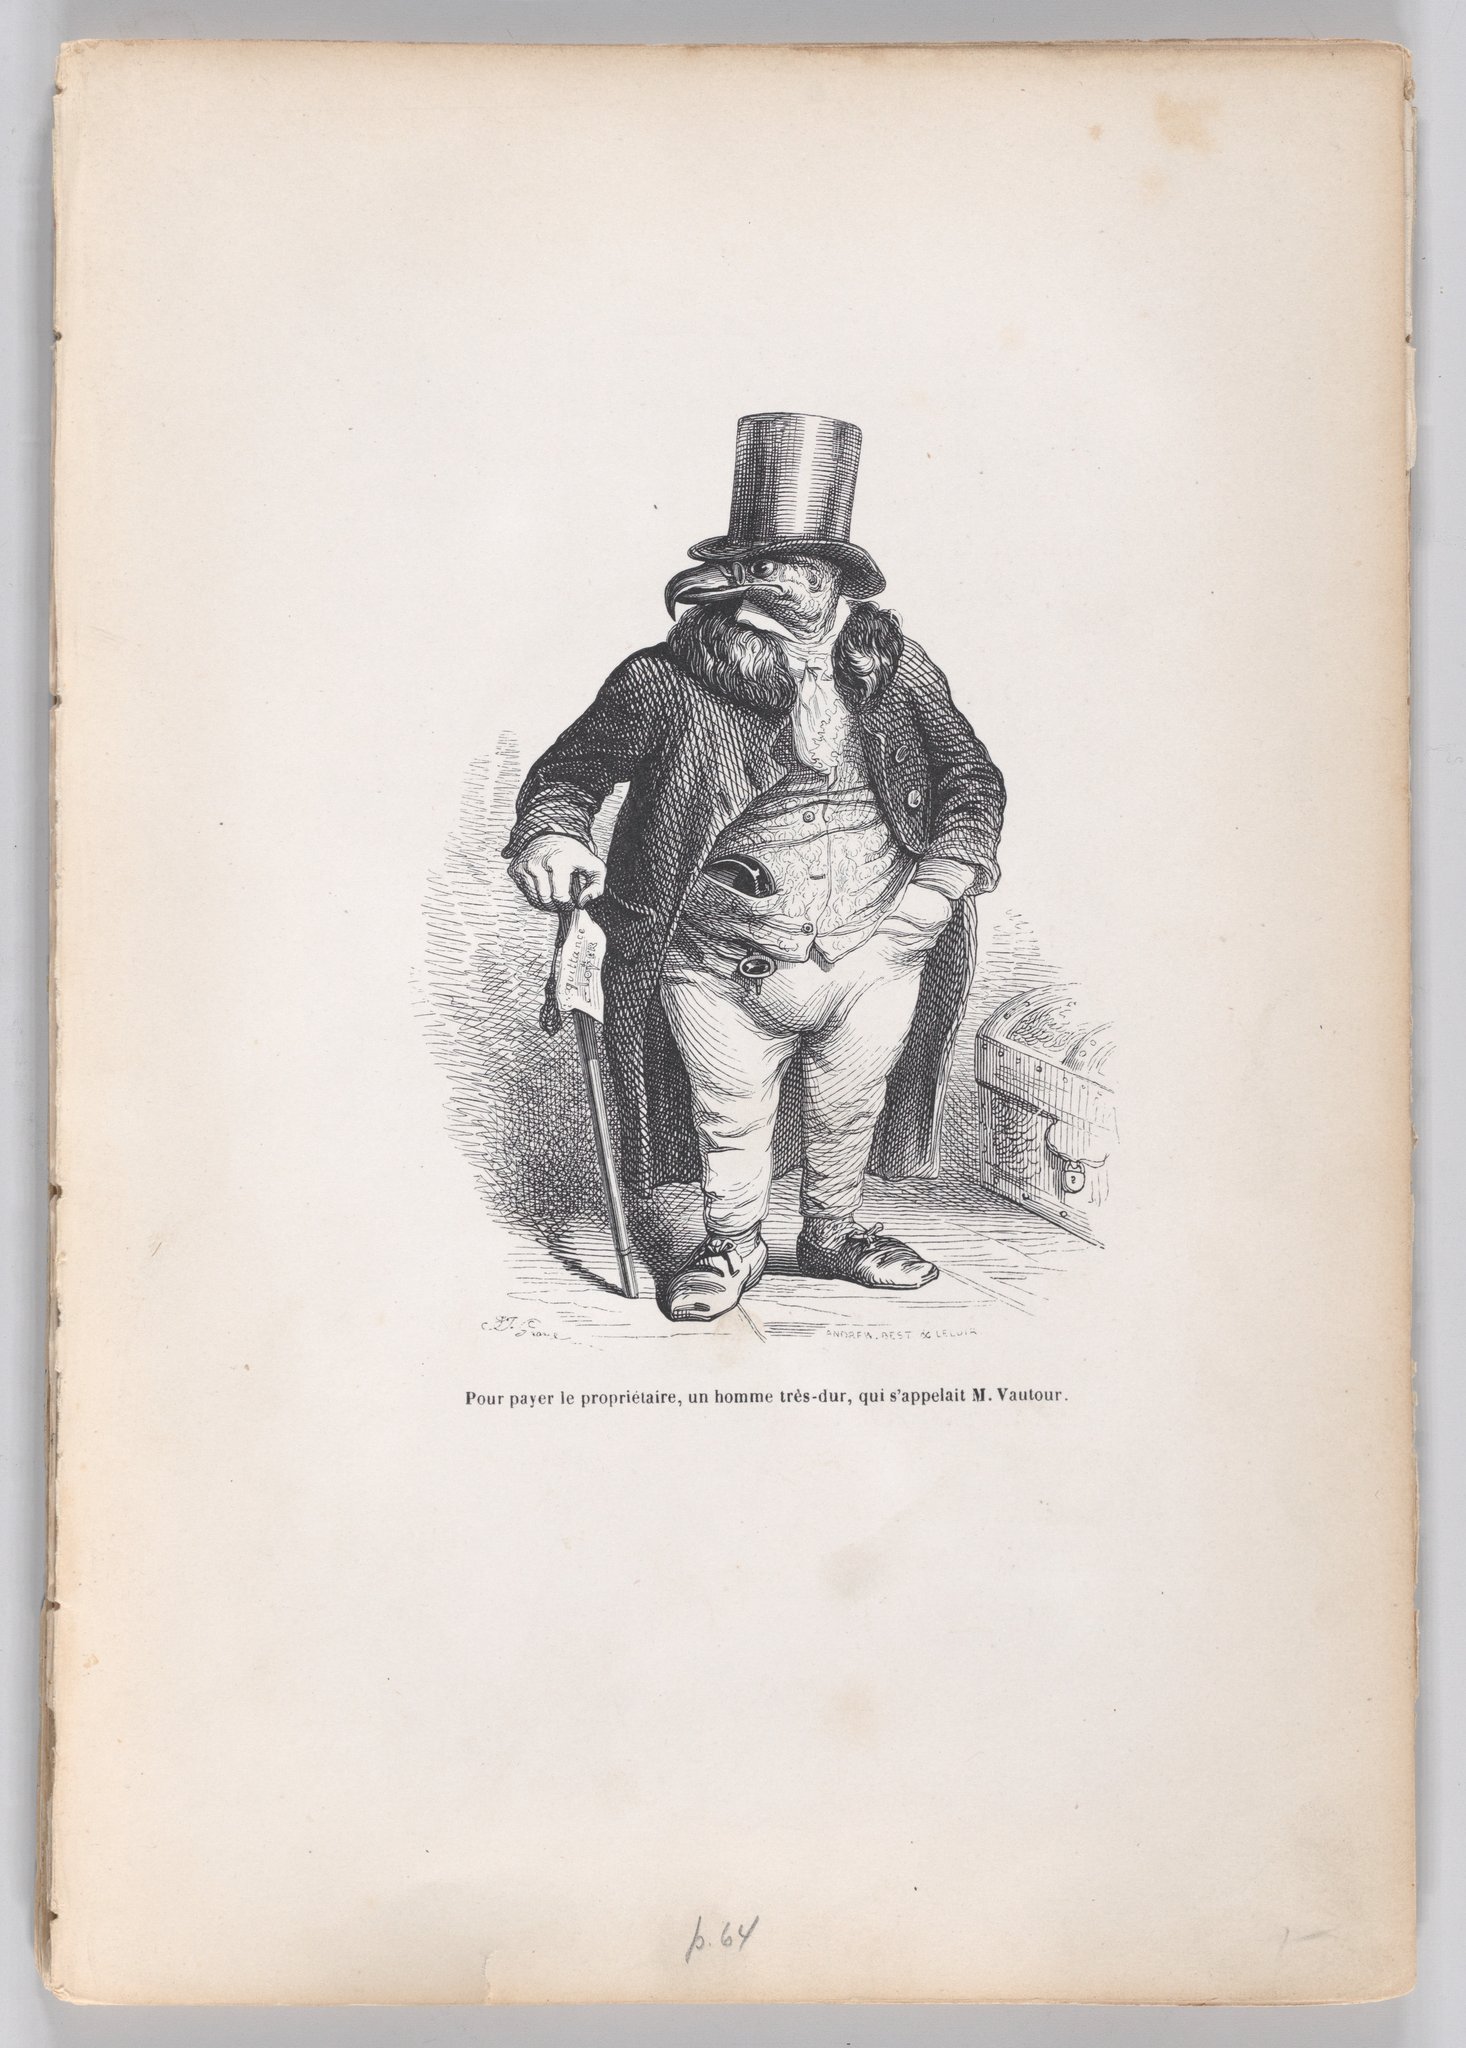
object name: print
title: To pay the landlord, a very harsh man, whose name was M. Vautour, from "Scenes from the Private and Public Life of Animals"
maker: j. j. grandville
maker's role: illustrator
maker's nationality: french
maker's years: 1803-1847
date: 1837-1847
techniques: engraving